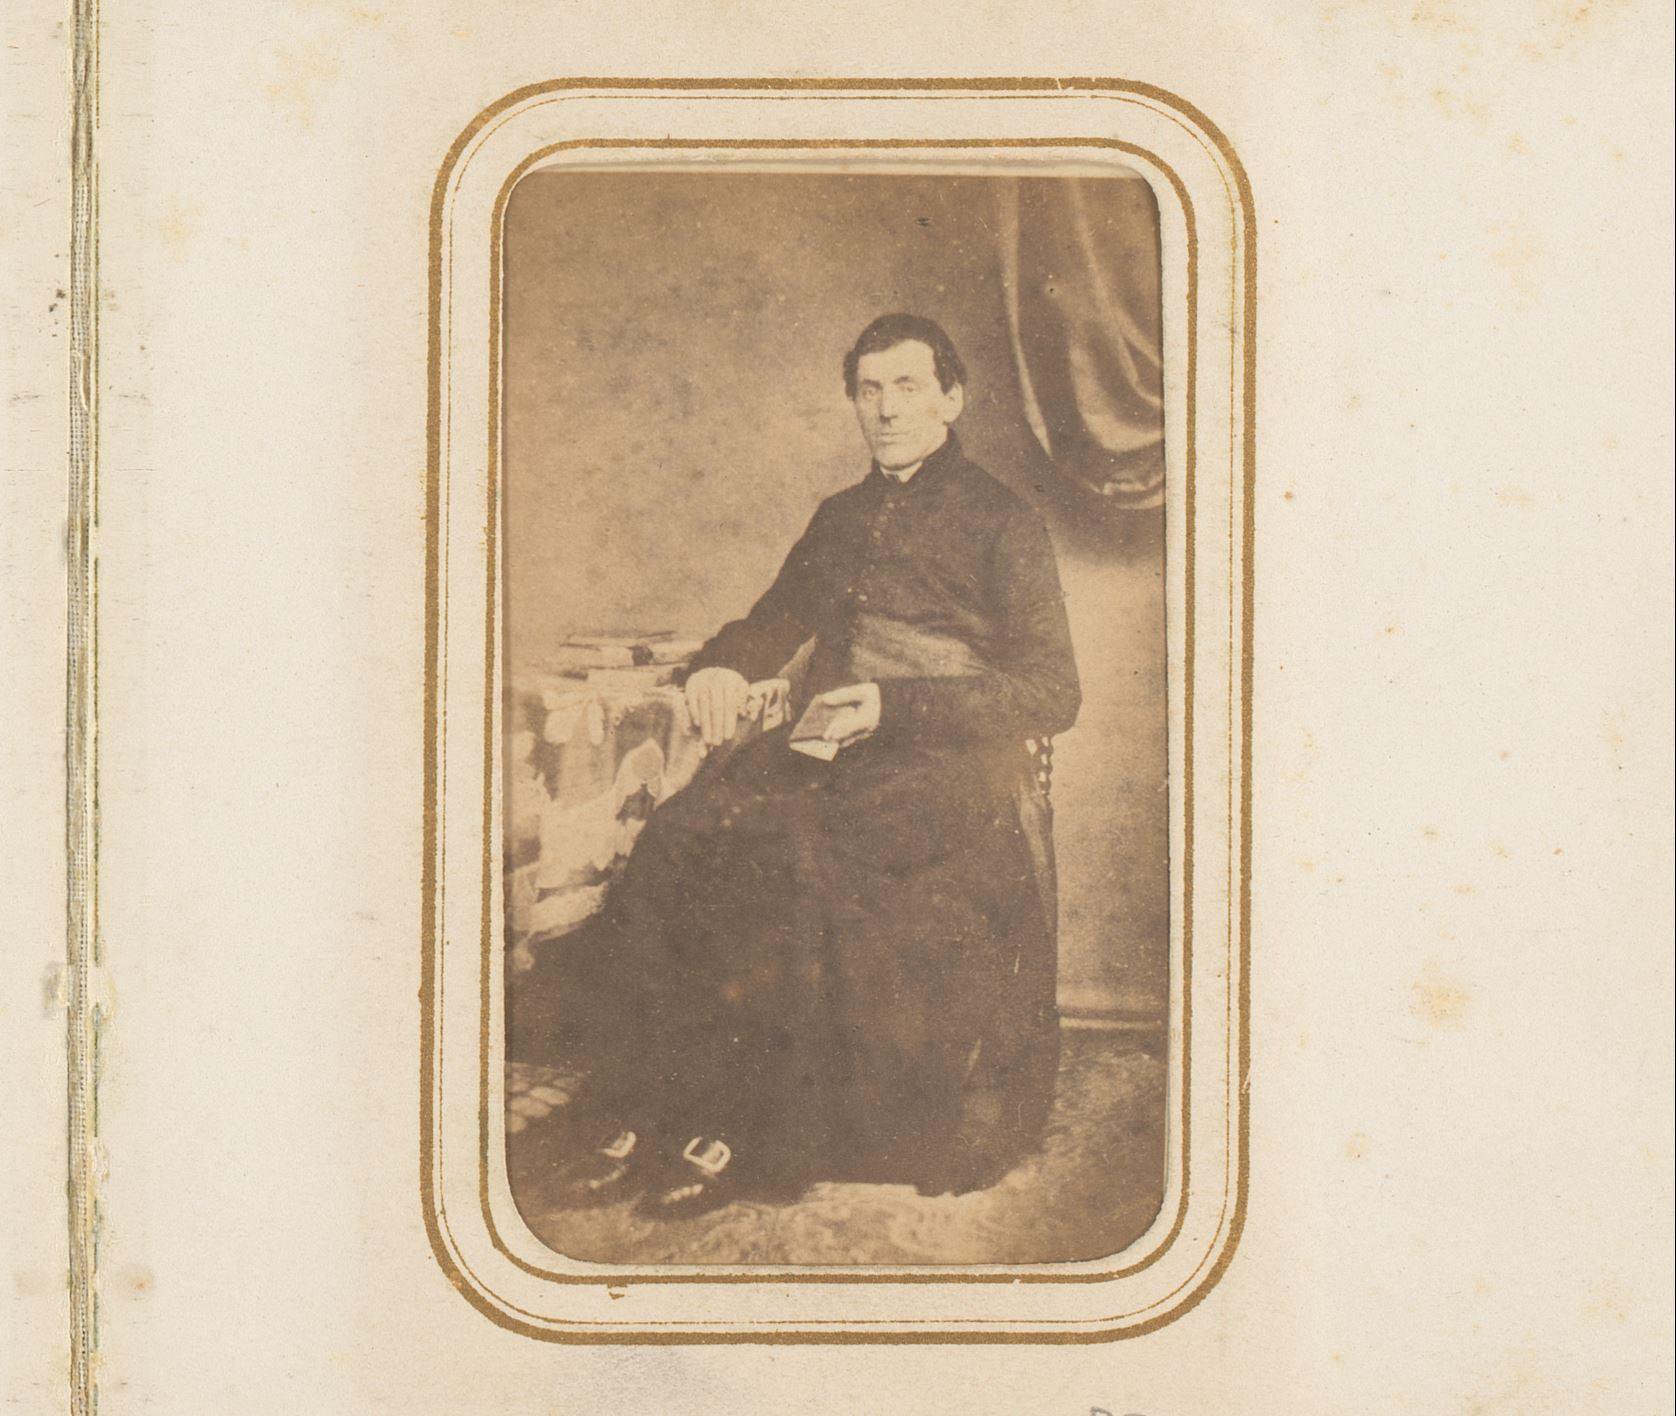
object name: photograph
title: Portret van een man, aangeduid als Hartman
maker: Anonymous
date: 1850-1880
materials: cardboard, photographic support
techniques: albumen print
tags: historical persons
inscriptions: annotation: ‘Hartman’